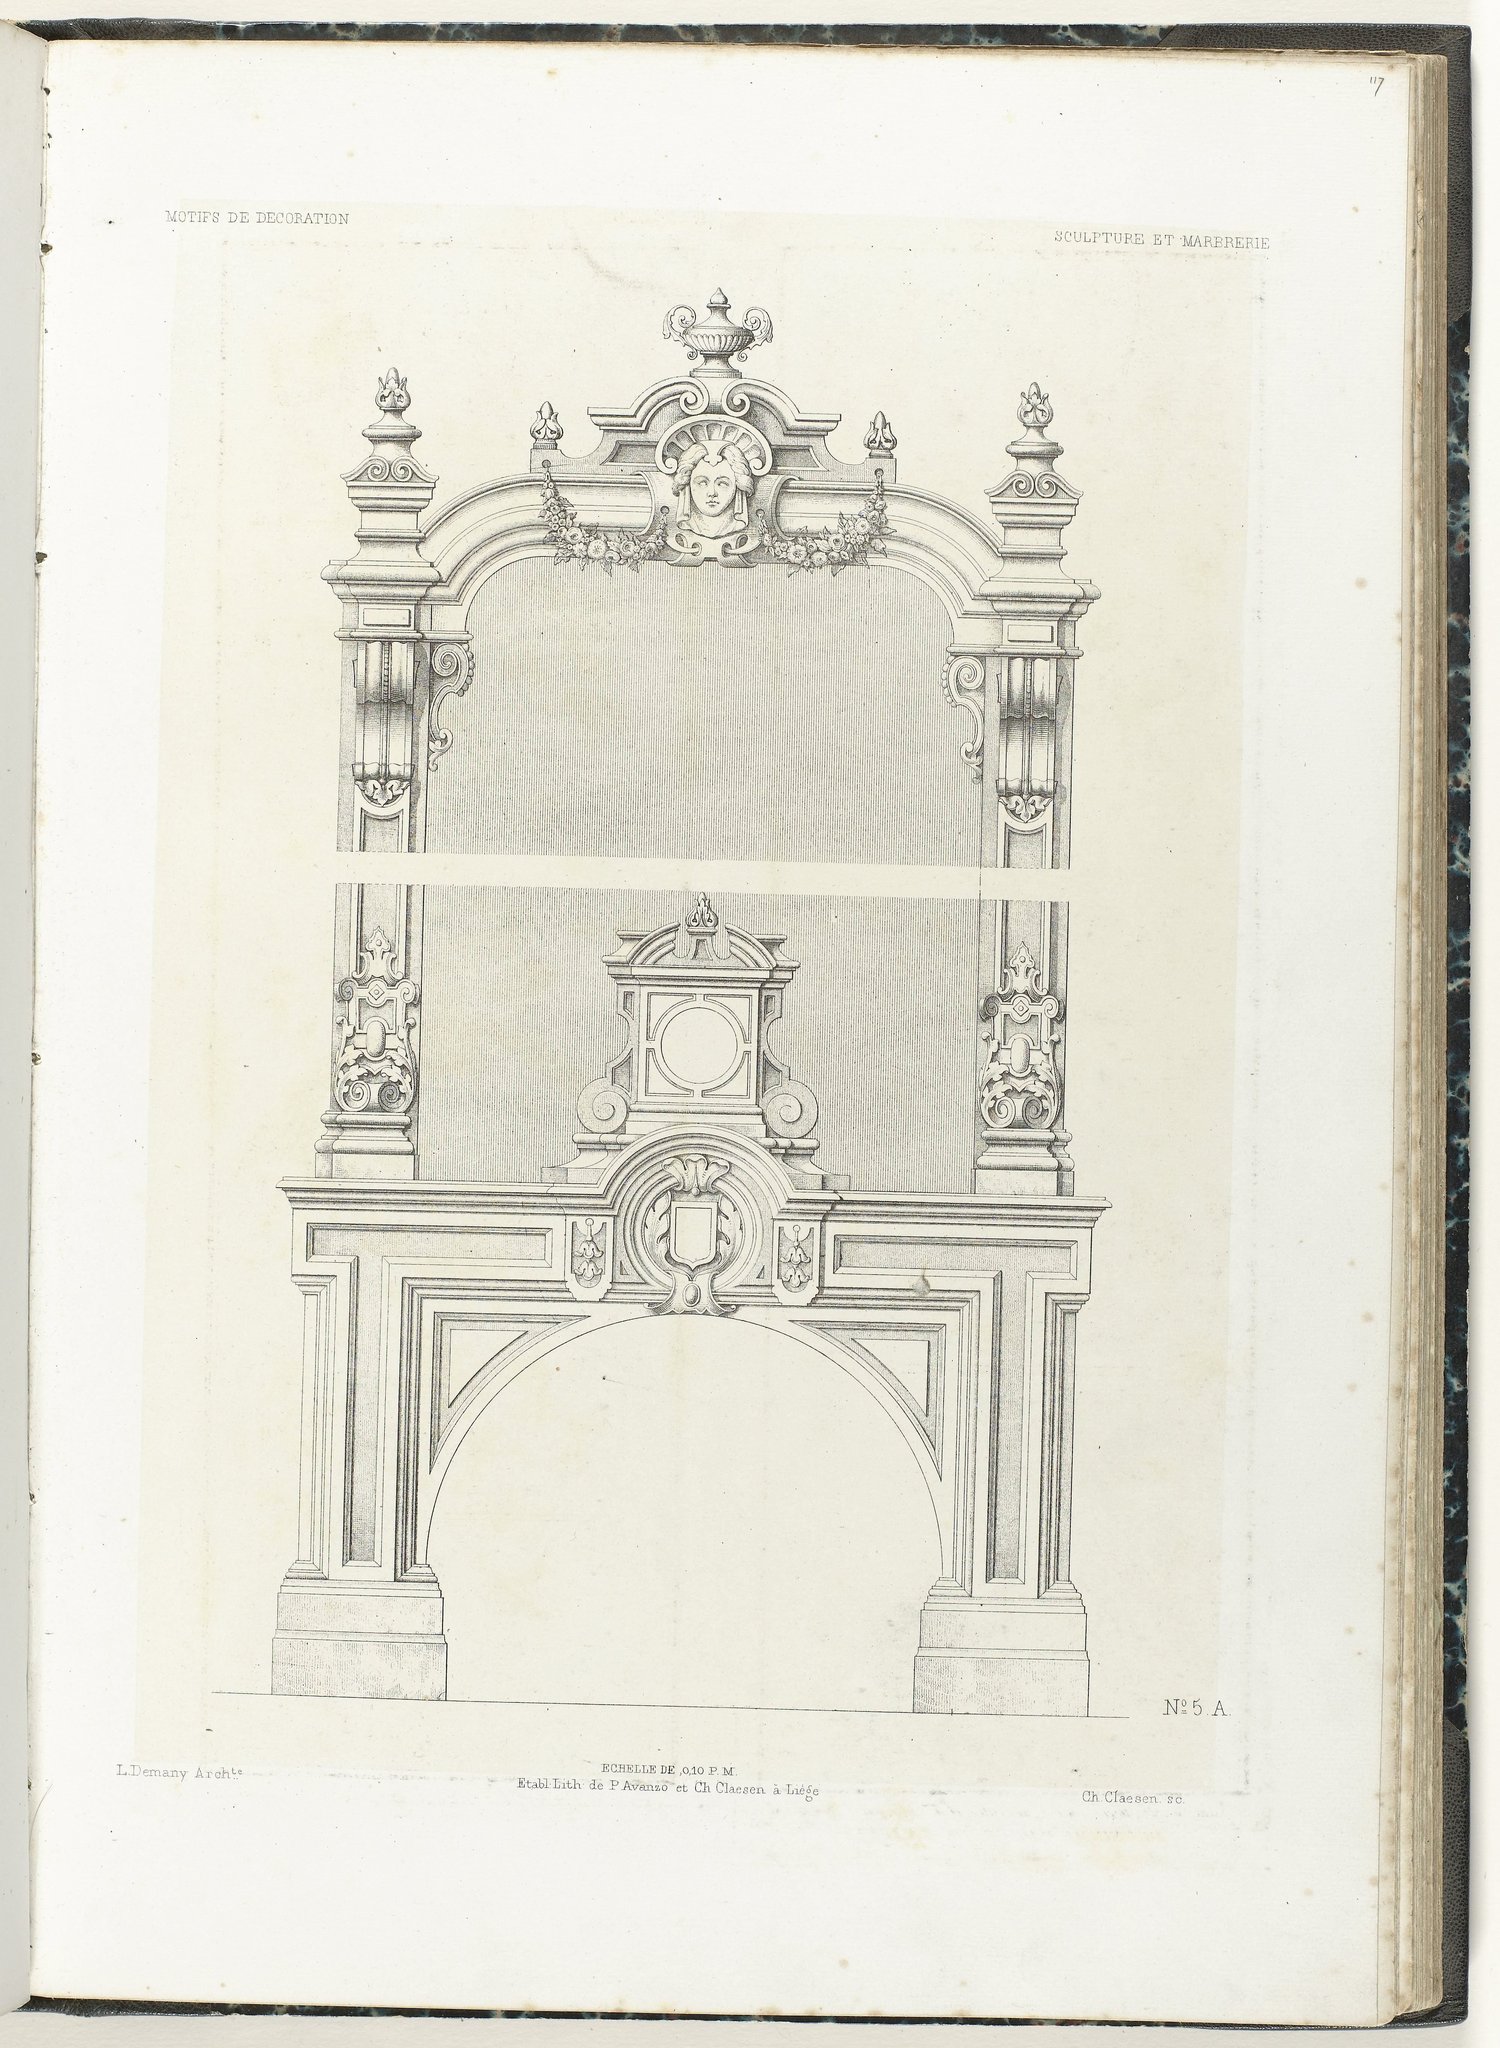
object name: print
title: Boven- en onderkant van onderboezem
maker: laurent demany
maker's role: architect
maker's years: 1827-1898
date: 1866-1900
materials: paper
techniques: tone lithography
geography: liège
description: Onderaan staat op de schoorsteenplaat een klok zonder wijzerplaat waaronder een klein leeg schild hangt. Linksboven staat vermeld: Motifs de decoration, rechtsboven: Sculpture et marbrerie, rechtsonder: N° 5.A.